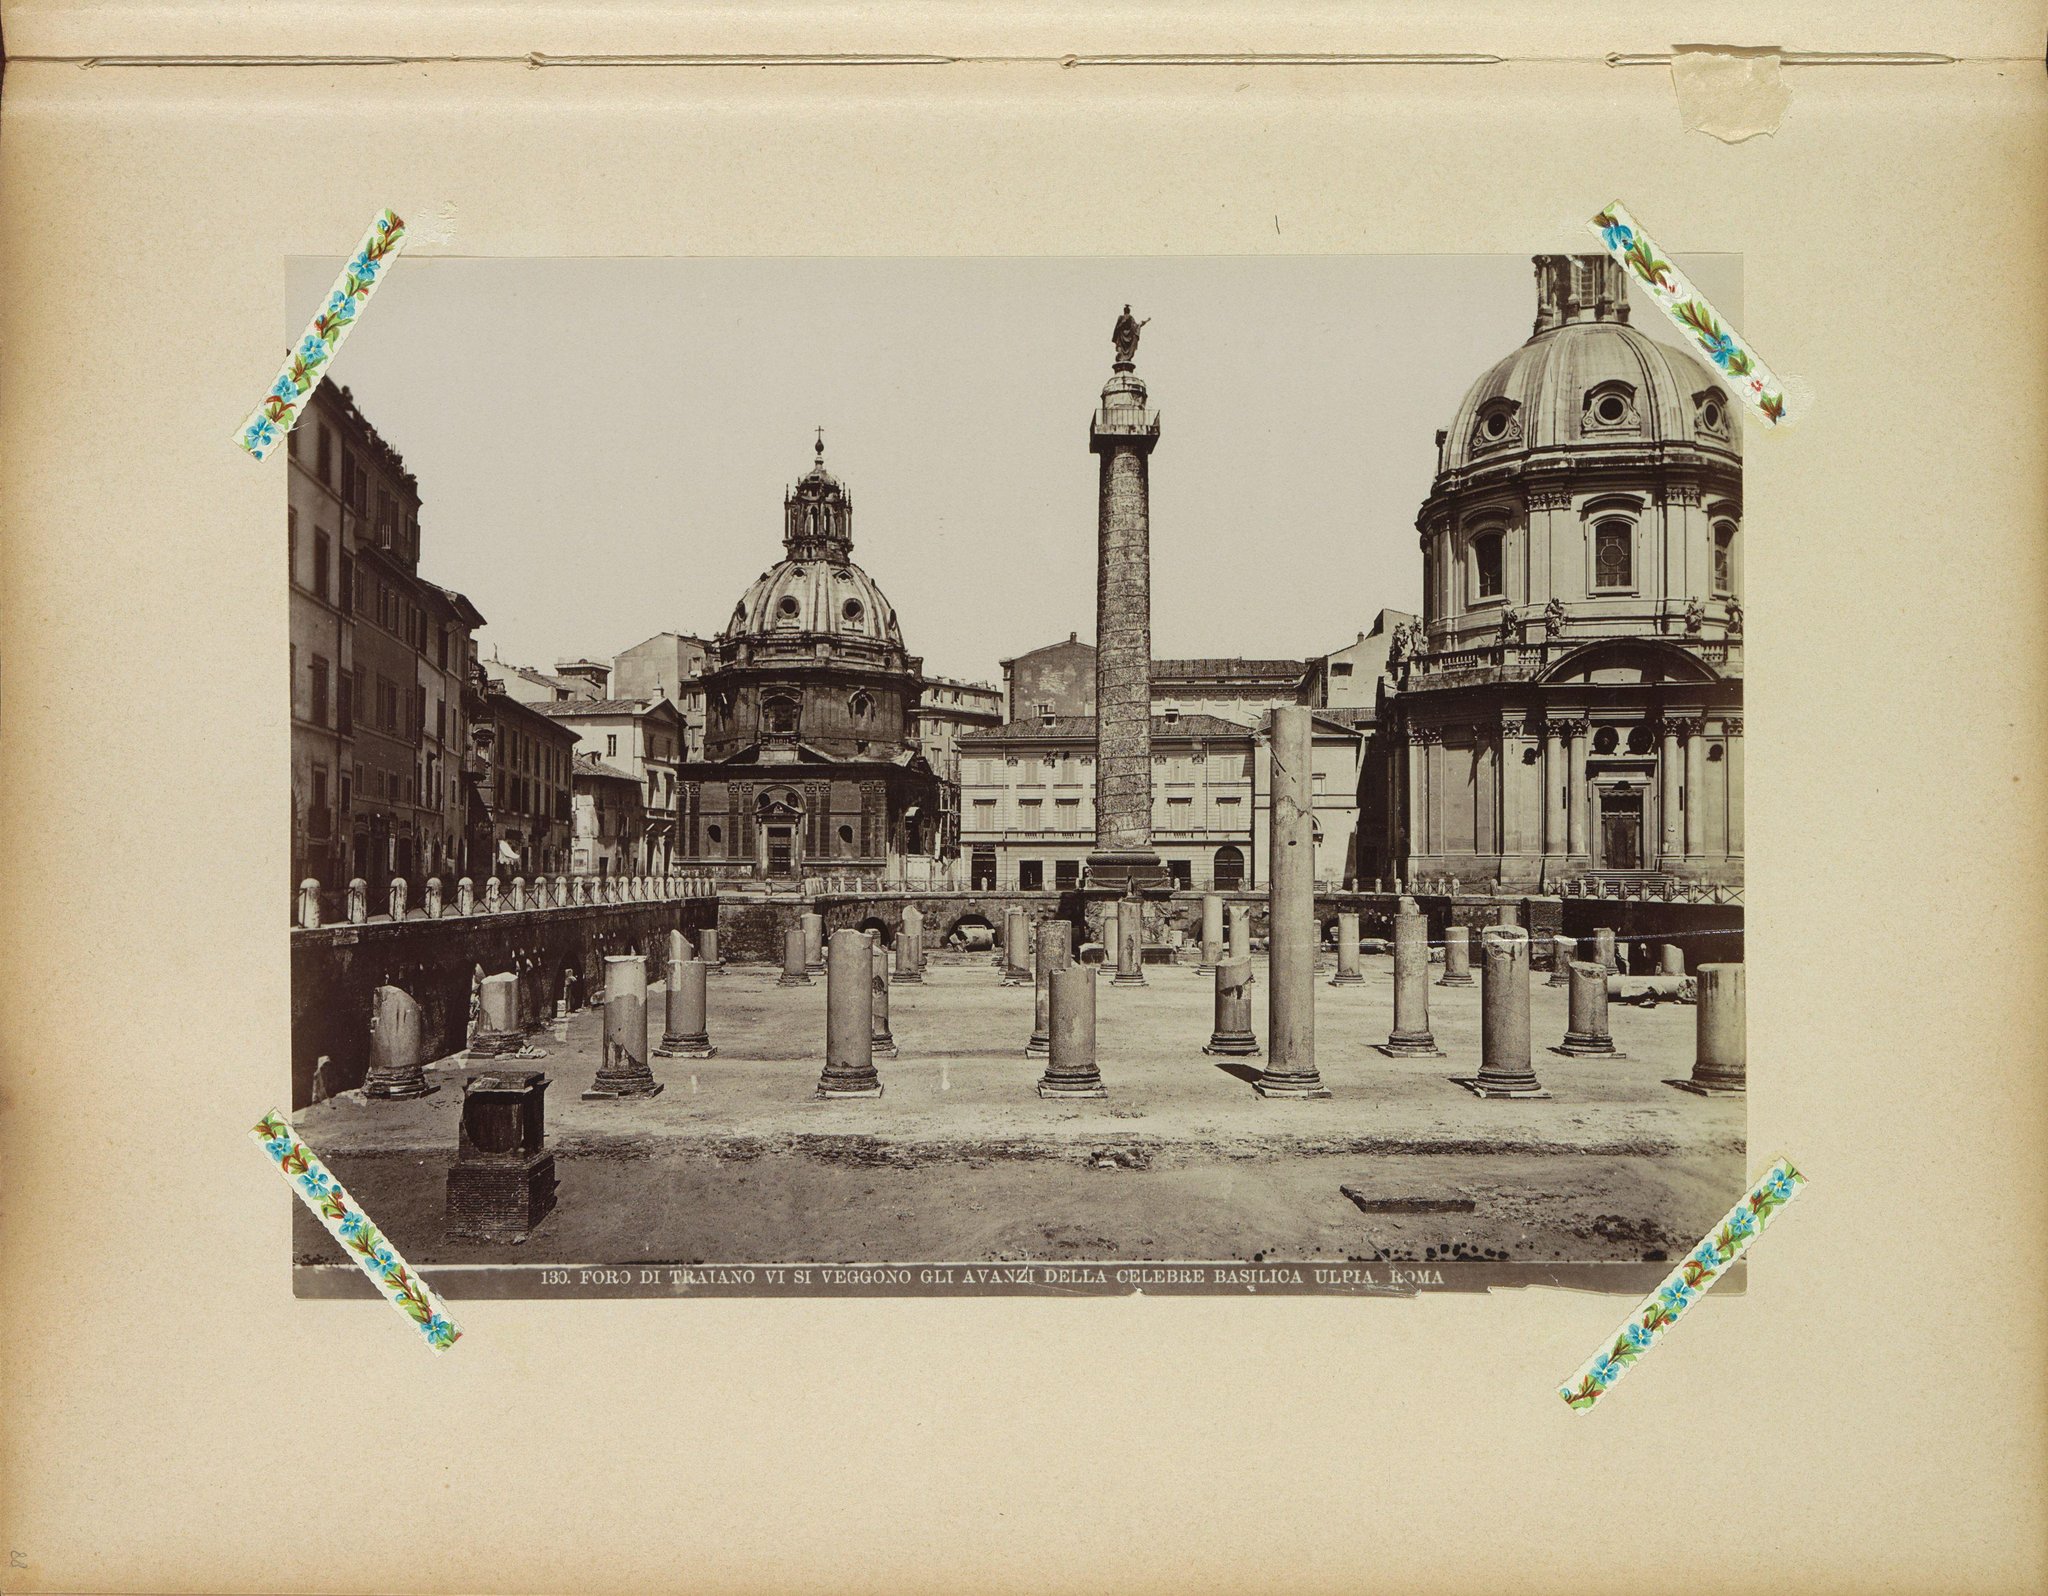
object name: photograph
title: Foro di Traiano vi si Veggono gli avanzi della celebre Basilica Ulpia. Roma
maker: Anonymous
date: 1860-1900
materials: photographic support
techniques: albumen print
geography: forum of trajan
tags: monument, statue, temple, shrine ~ roman religion, square, place, circus, etc. (+ city(-scape) with figures, staffage)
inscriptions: number: ‘130’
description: Onderdeel van Fotoalbum met opnames van bezienswaardigheden in Italiaanse steden en van kunstwerken.